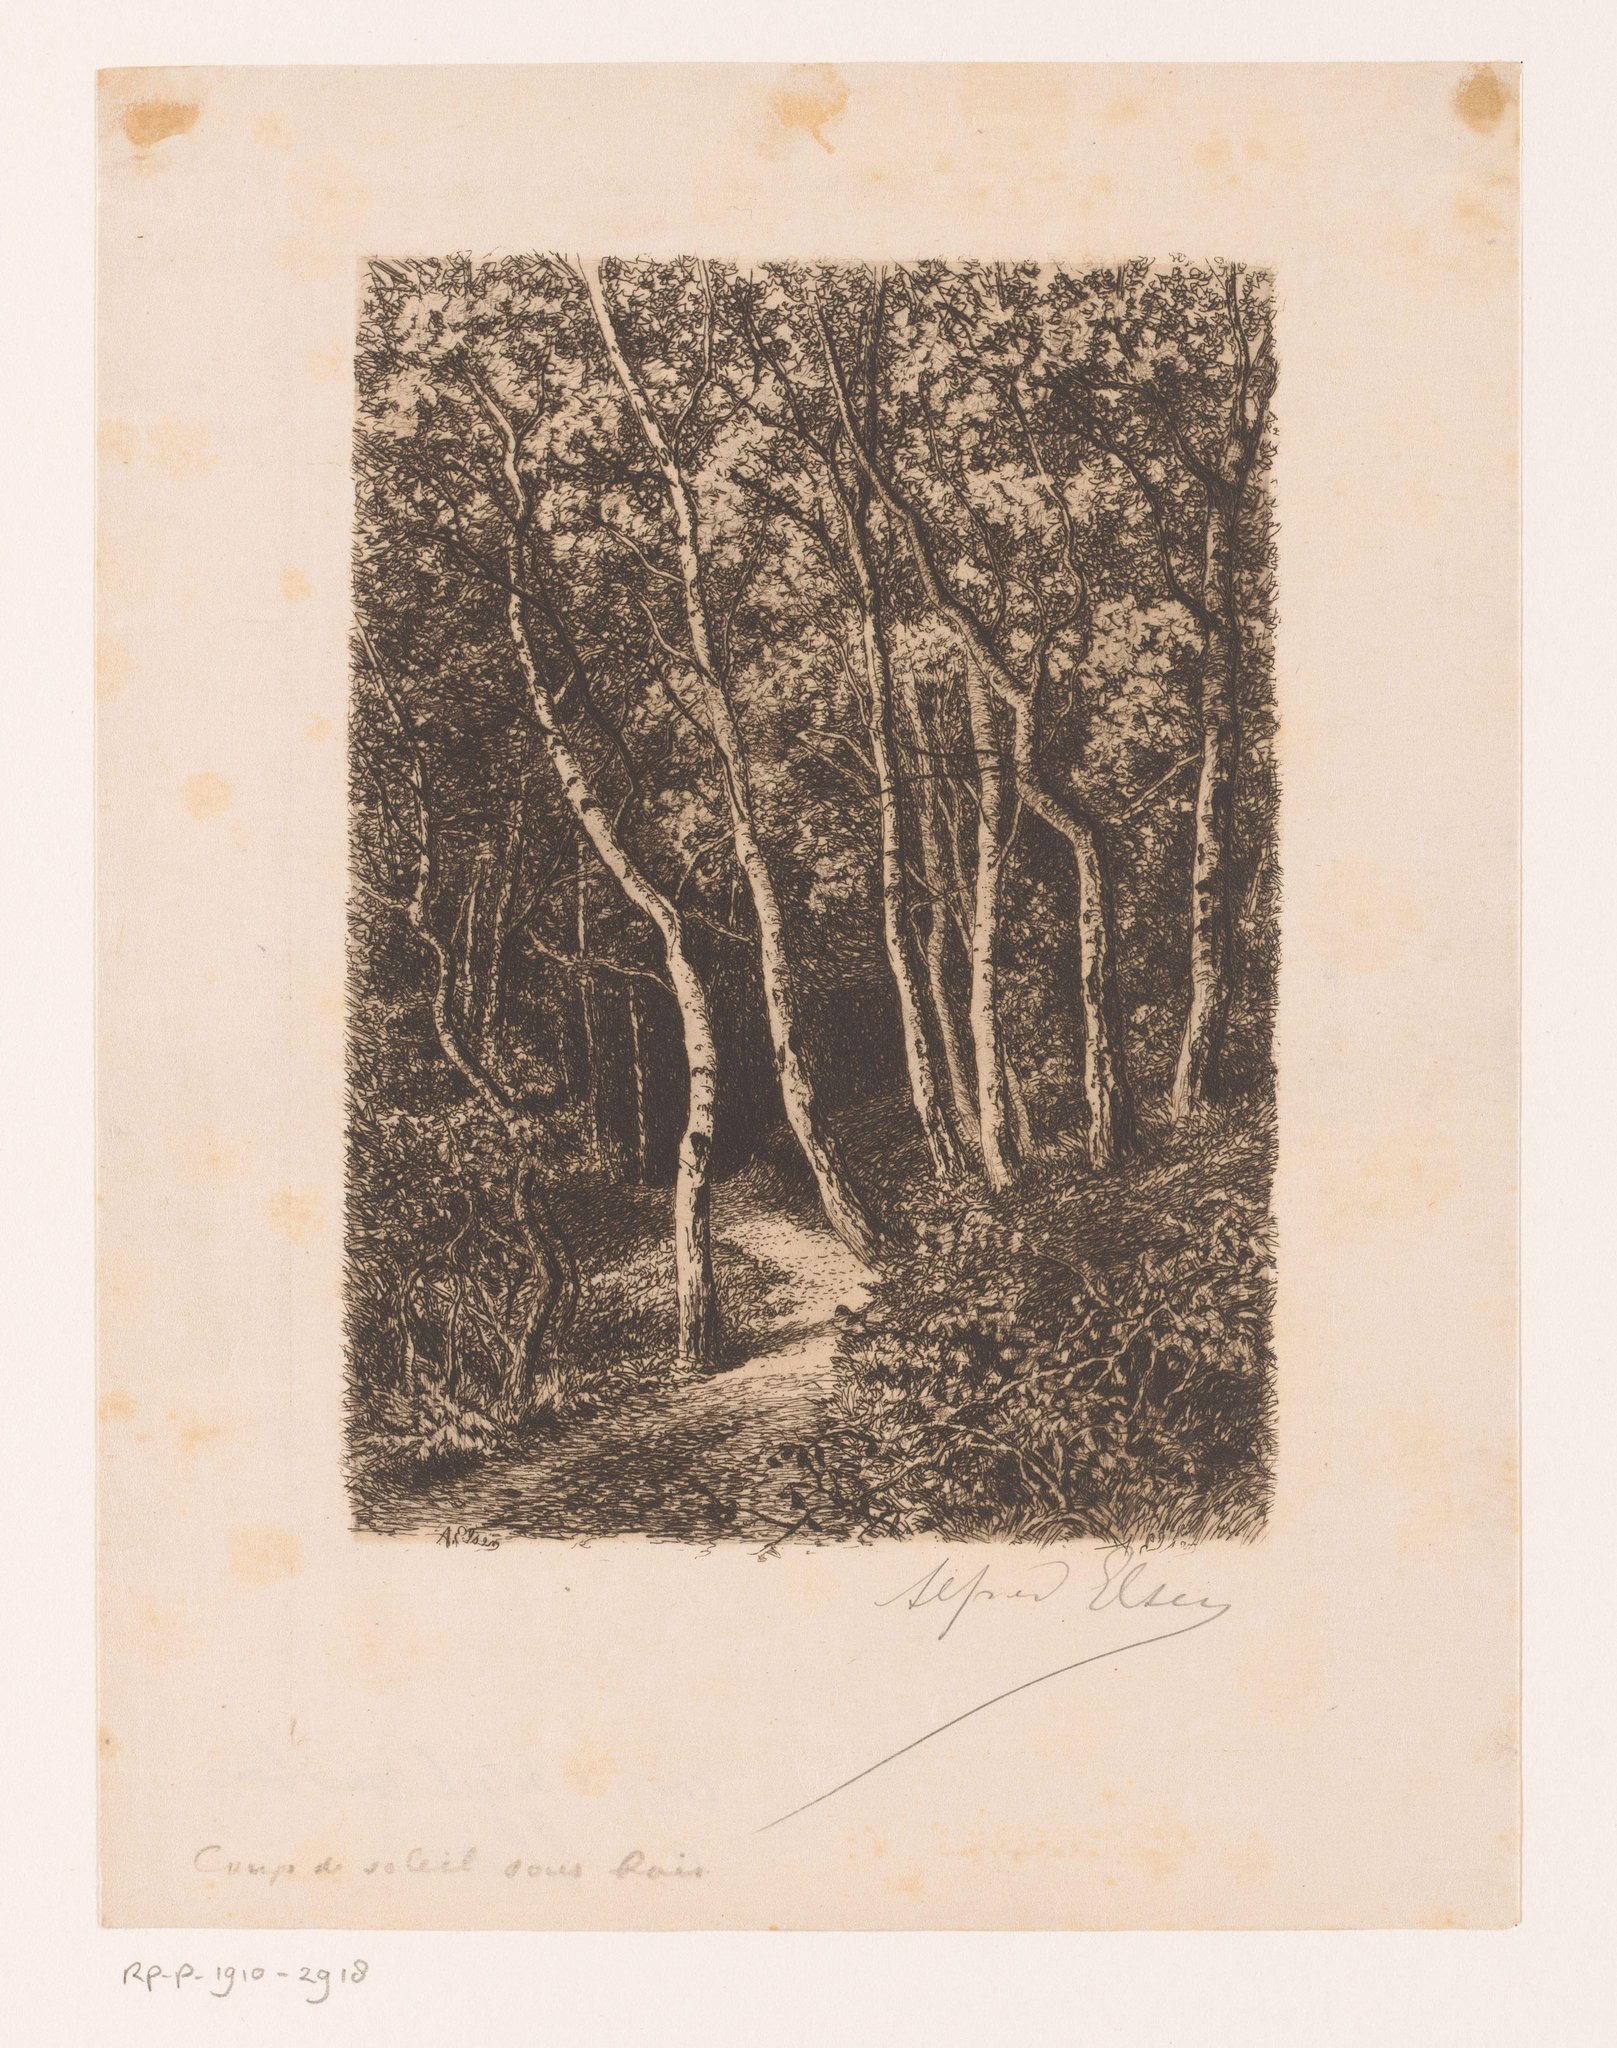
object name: print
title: Bosgezicht met bospad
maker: alfred elsen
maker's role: painter, print maker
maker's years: 1850-1914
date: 1860-1910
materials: paper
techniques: etching, intaglio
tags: road, path, forest, wood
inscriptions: collector's mark: Lugt 2228, mark: ‘Antwerpsche Etsers 1880’